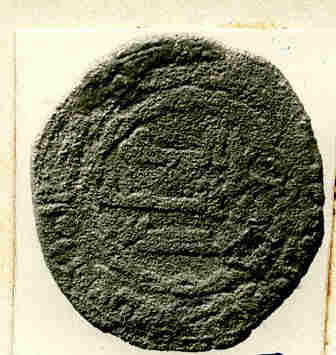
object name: coin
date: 144-761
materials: copper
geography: iran